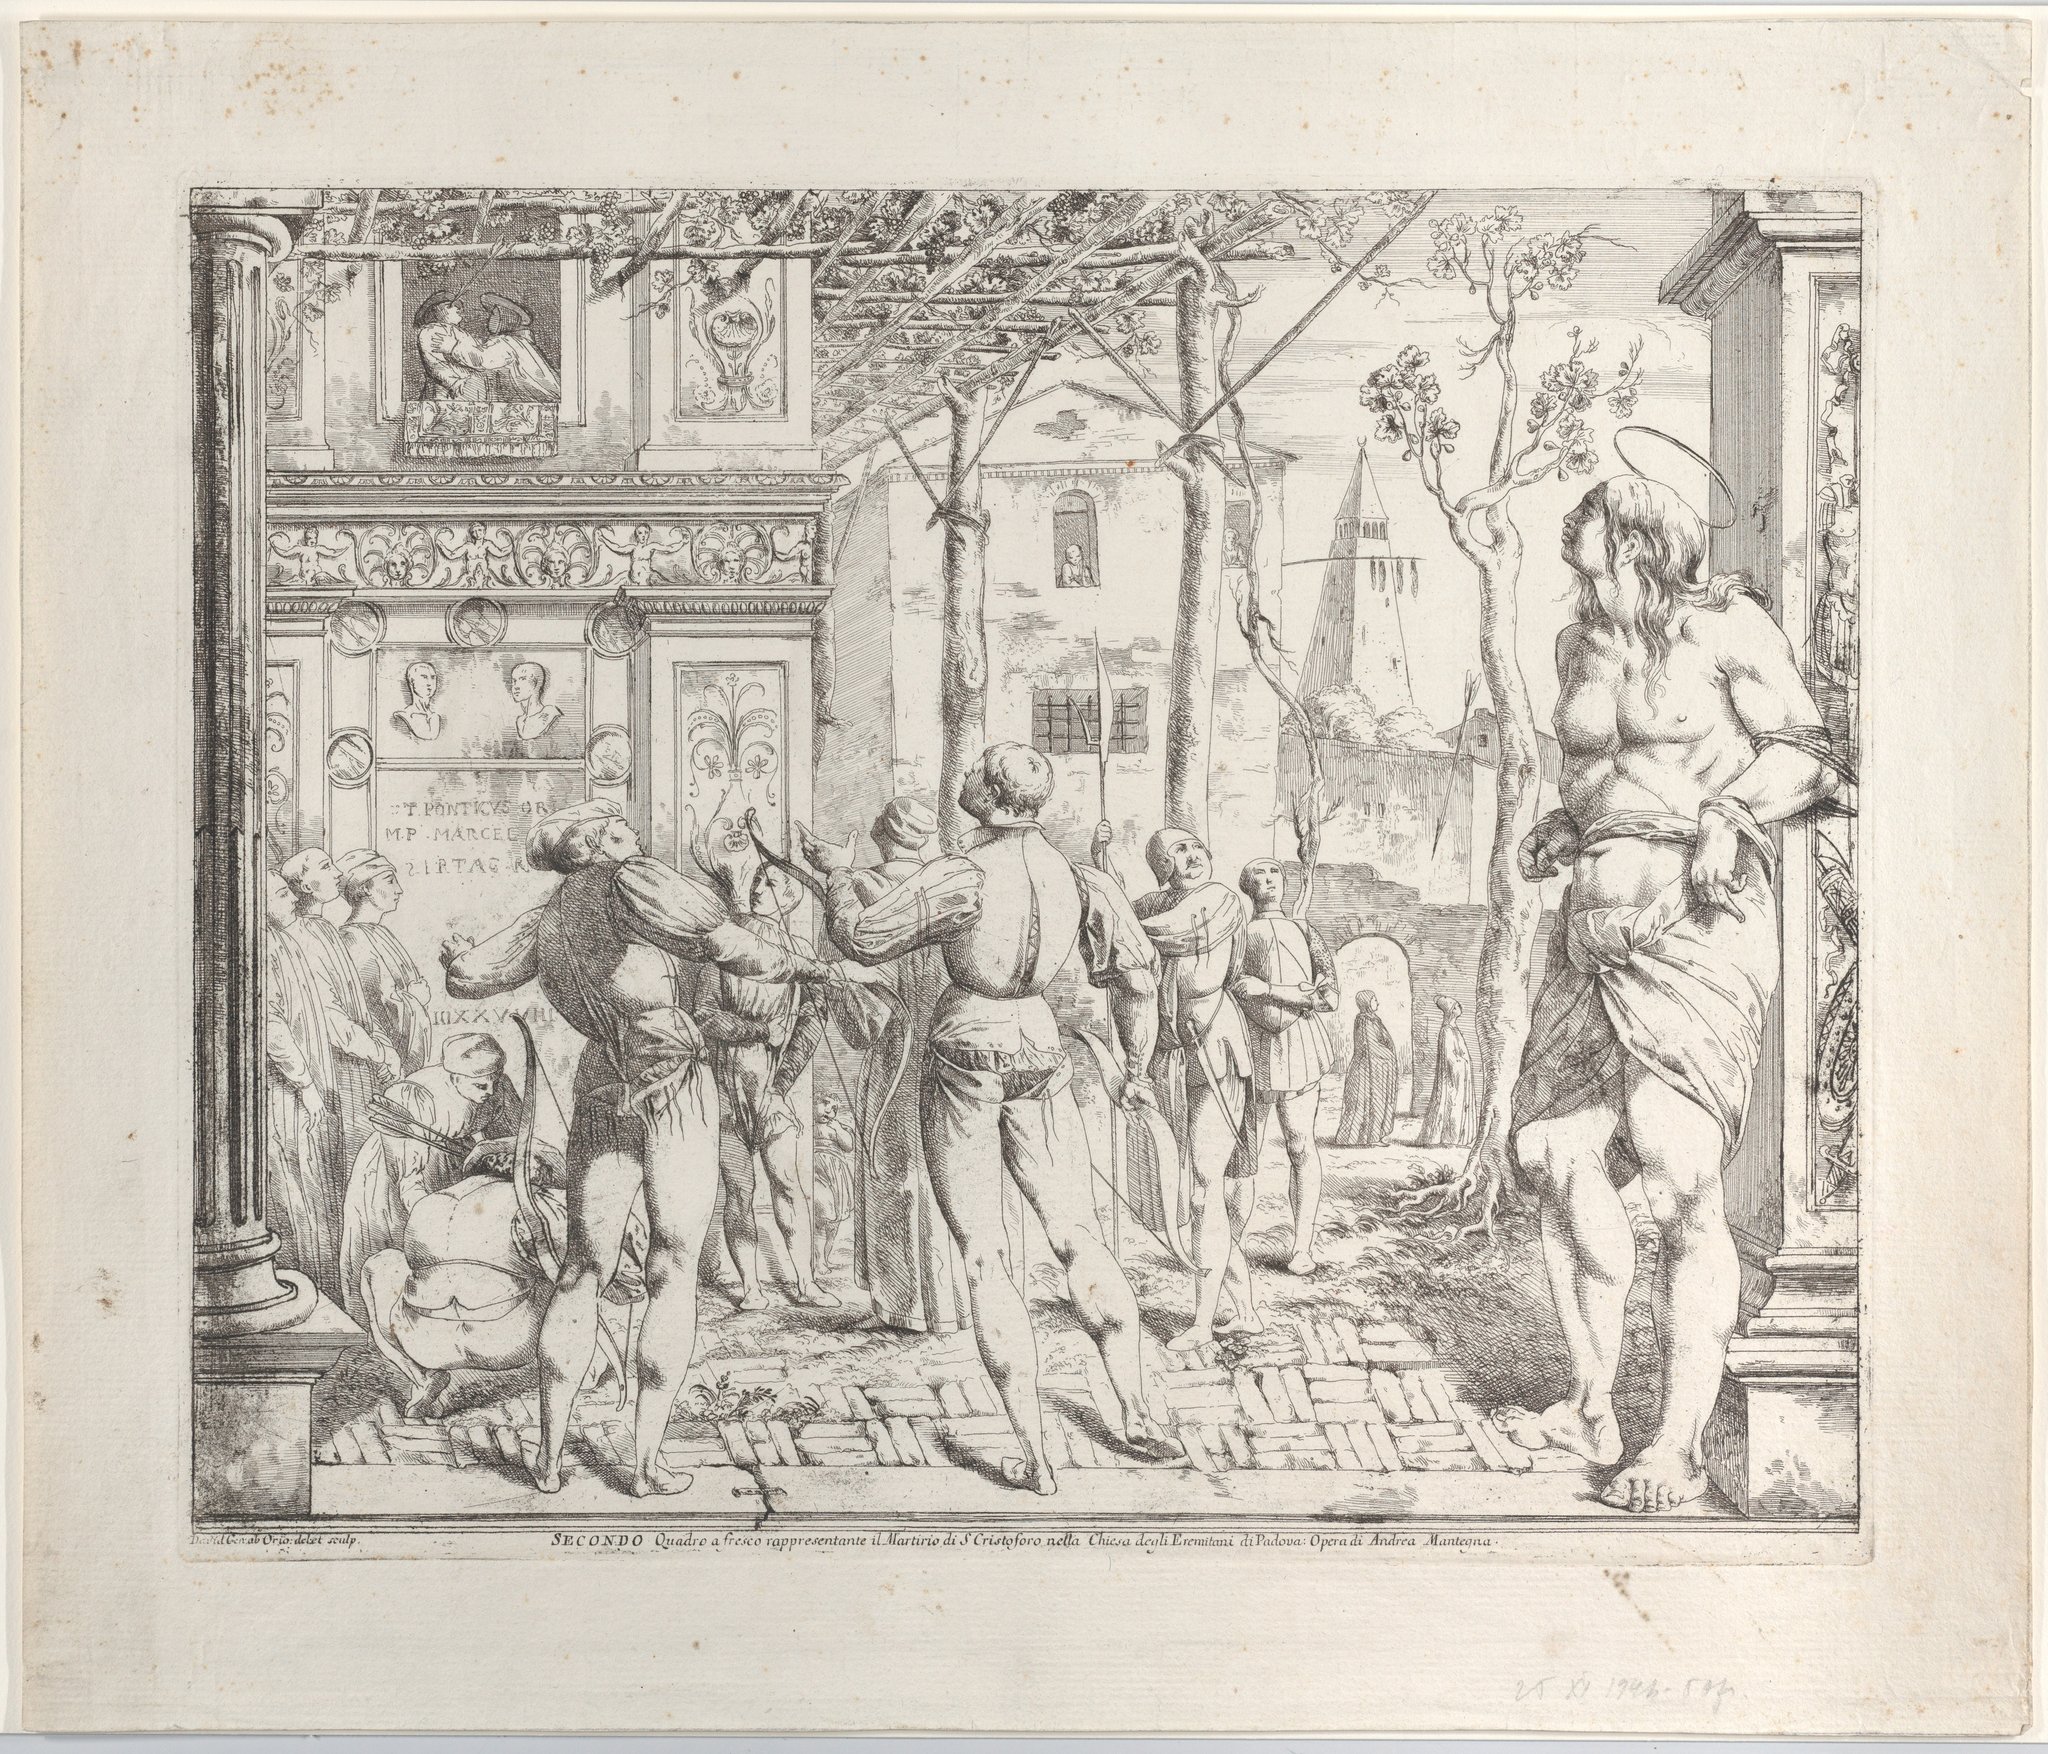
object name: print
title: The Martyrdom of Saint Christopher, "Secondo Quadro"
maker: giovanni david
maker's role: artist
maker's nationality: italian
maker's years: 1749-1790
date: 1776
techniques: etching